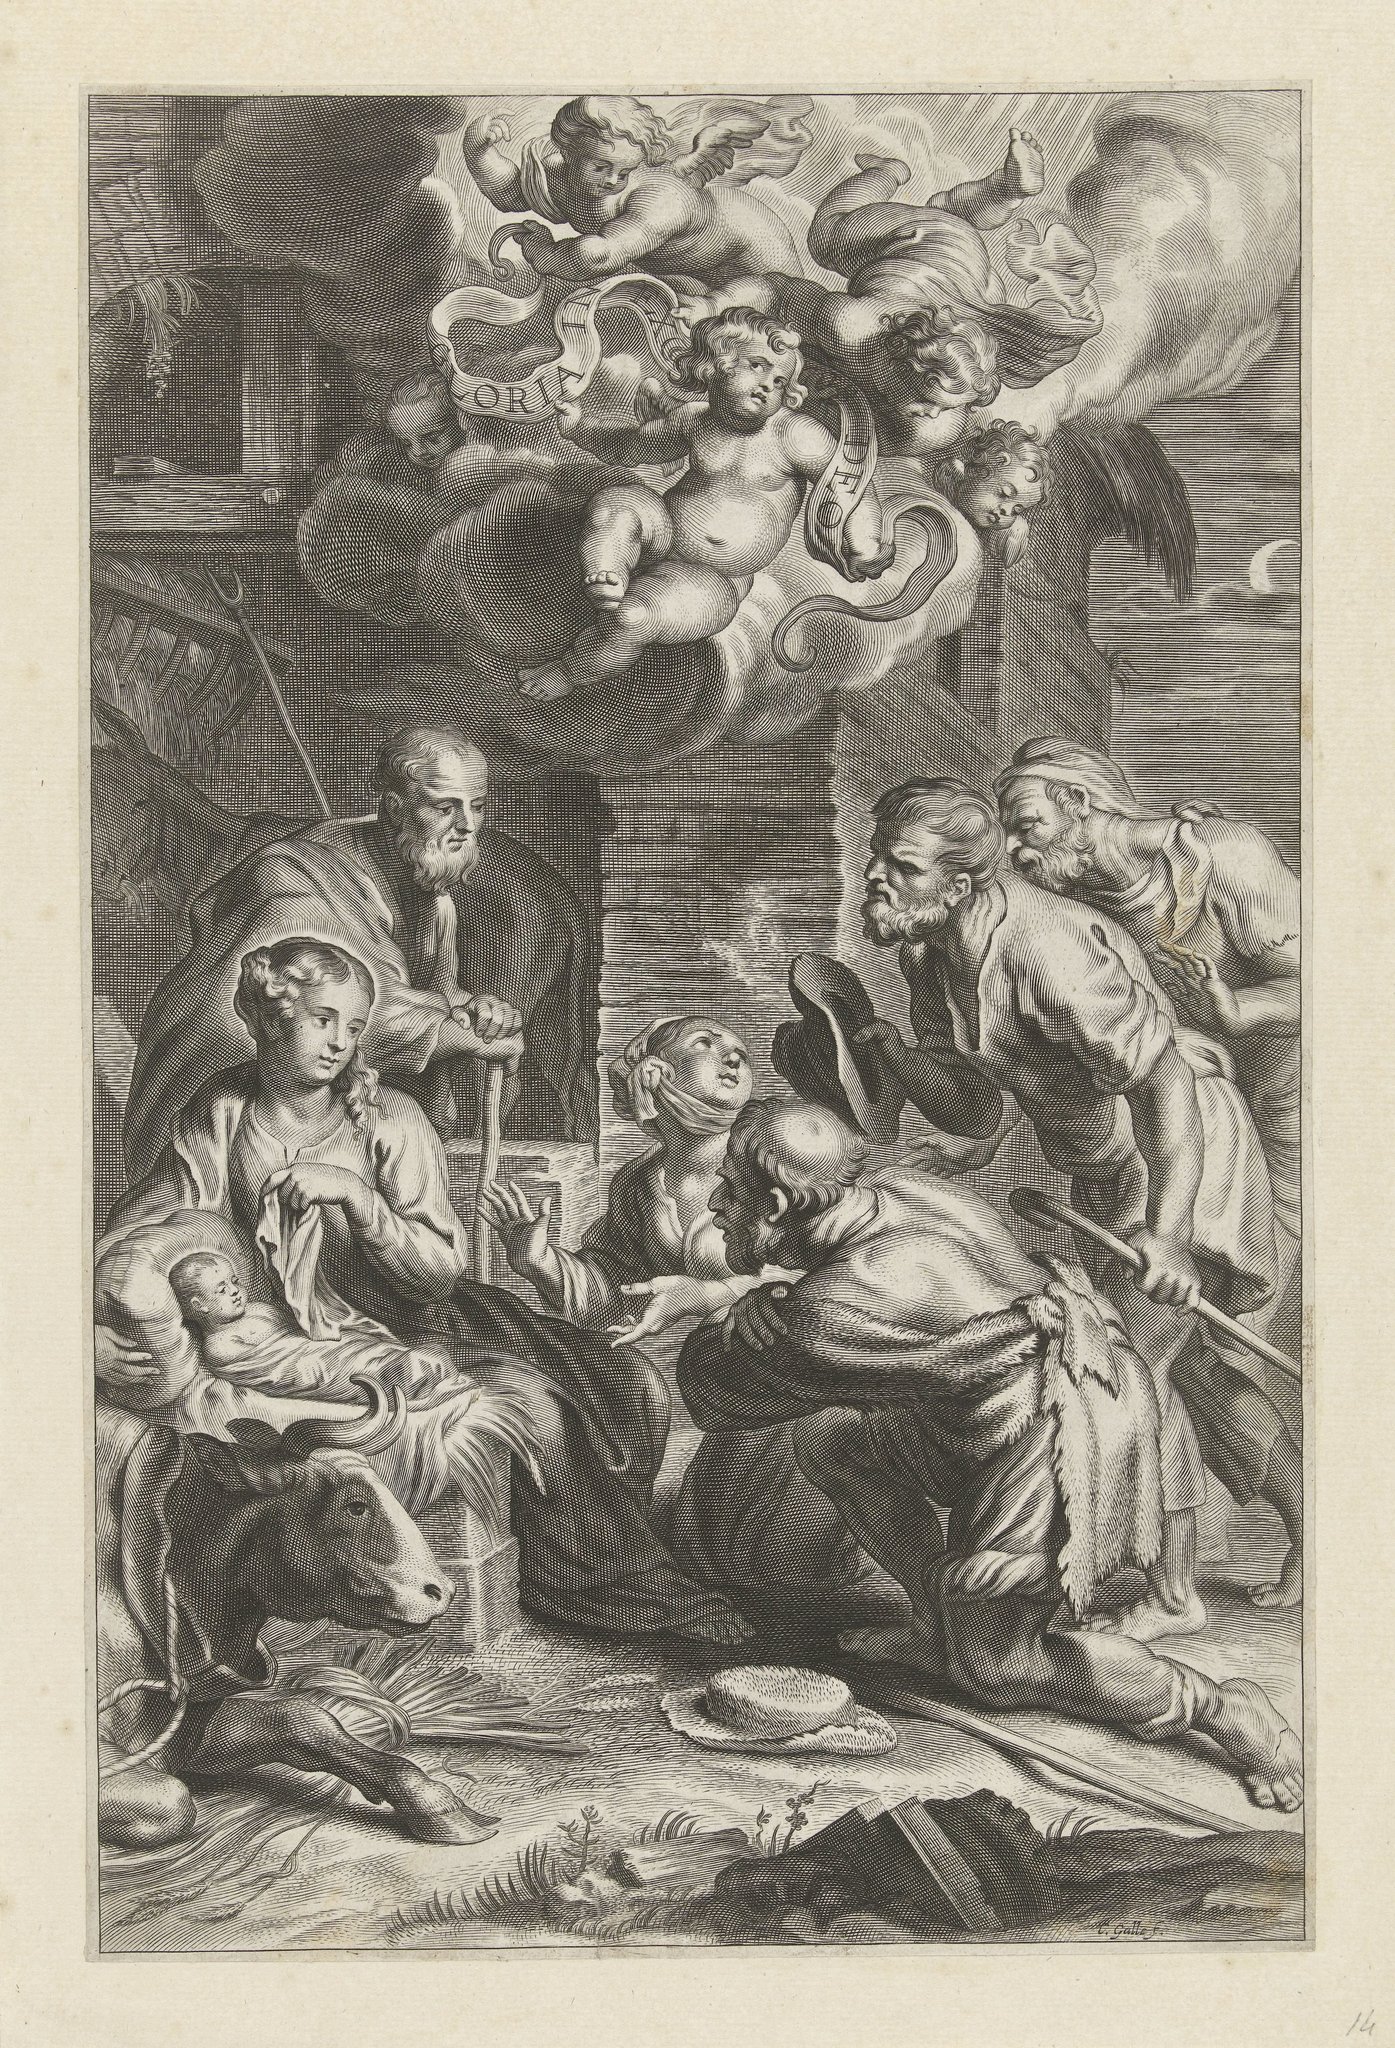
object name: book illustration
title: Aanbidding door de herders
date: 1650-1653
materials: paper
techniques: engraving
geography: antwerp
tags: adoration of the christ-child by the shepherds; mary and joseph present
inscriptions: collector's mark: Lugt 240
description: Illustratie voor: Missale Romanum ex decreto sacrosancti concilii Tridentini restitutum. Antwerpen: ex officina Plantiniana, B. Moretus, 1650 (tweede druk 1653).